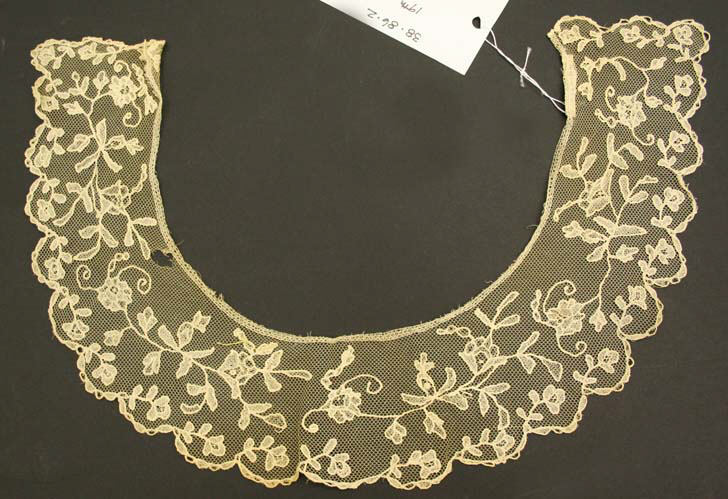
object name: collar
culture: american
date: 1868